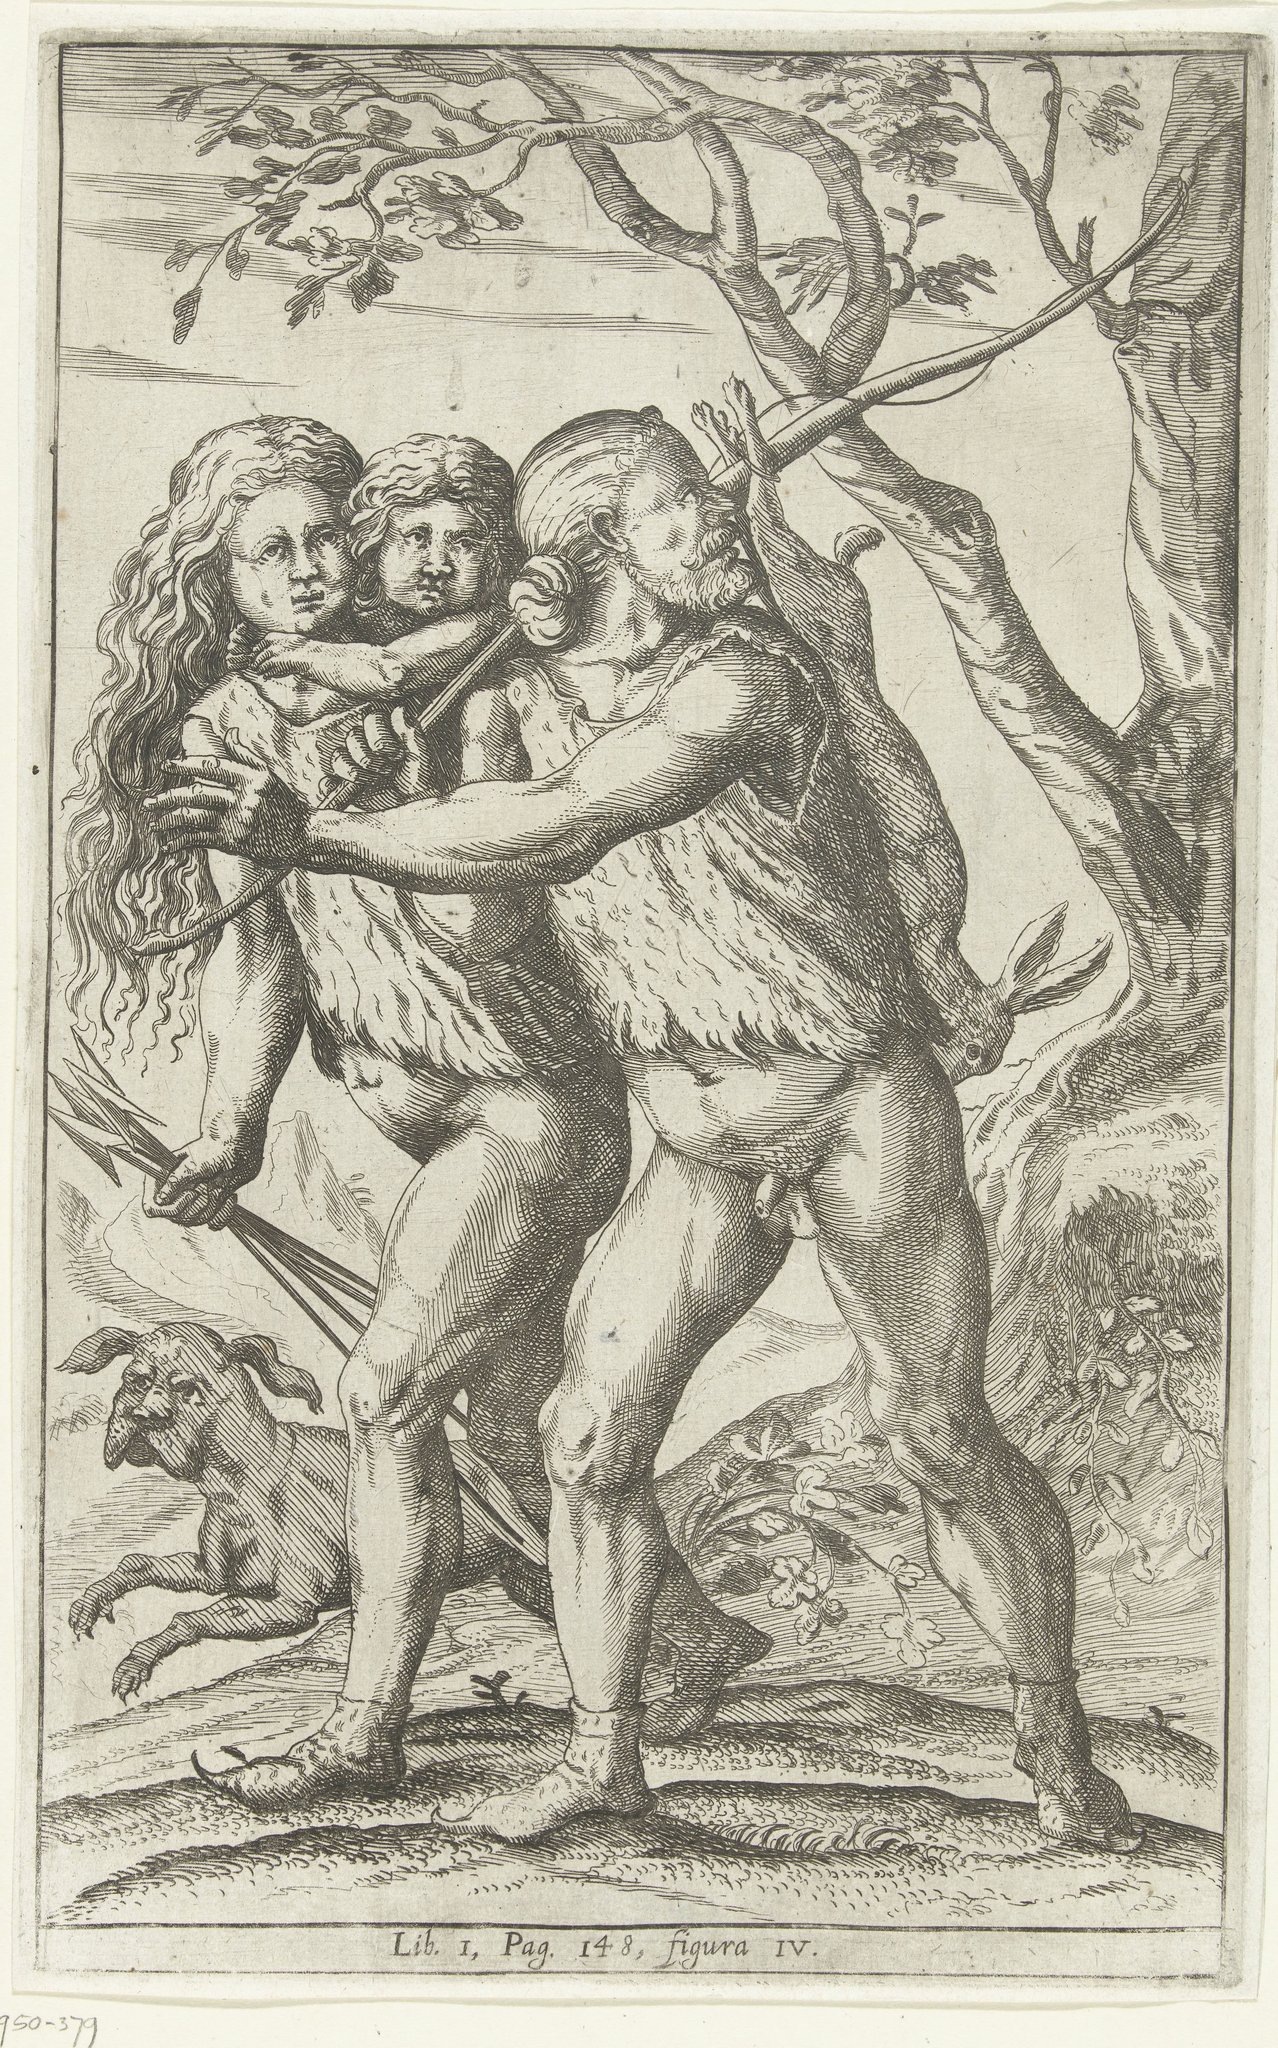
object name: print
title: Germaanse familie op jacht, figura IV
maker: nicolaes van geelkercken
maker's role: print maker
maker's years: 1585-1656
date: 1614-1616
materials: paper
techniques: etching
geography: netherlands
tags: extinct, 'historical' peoples (with name)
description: Germaanse familie op jacht. Afkomstig uit: Philippus Cluverius, Germaniæ antiquæ libri tres, Lowijs (I) Elzevier, Leiden, 1616. Lib. I, Pag. 148, figura IV.